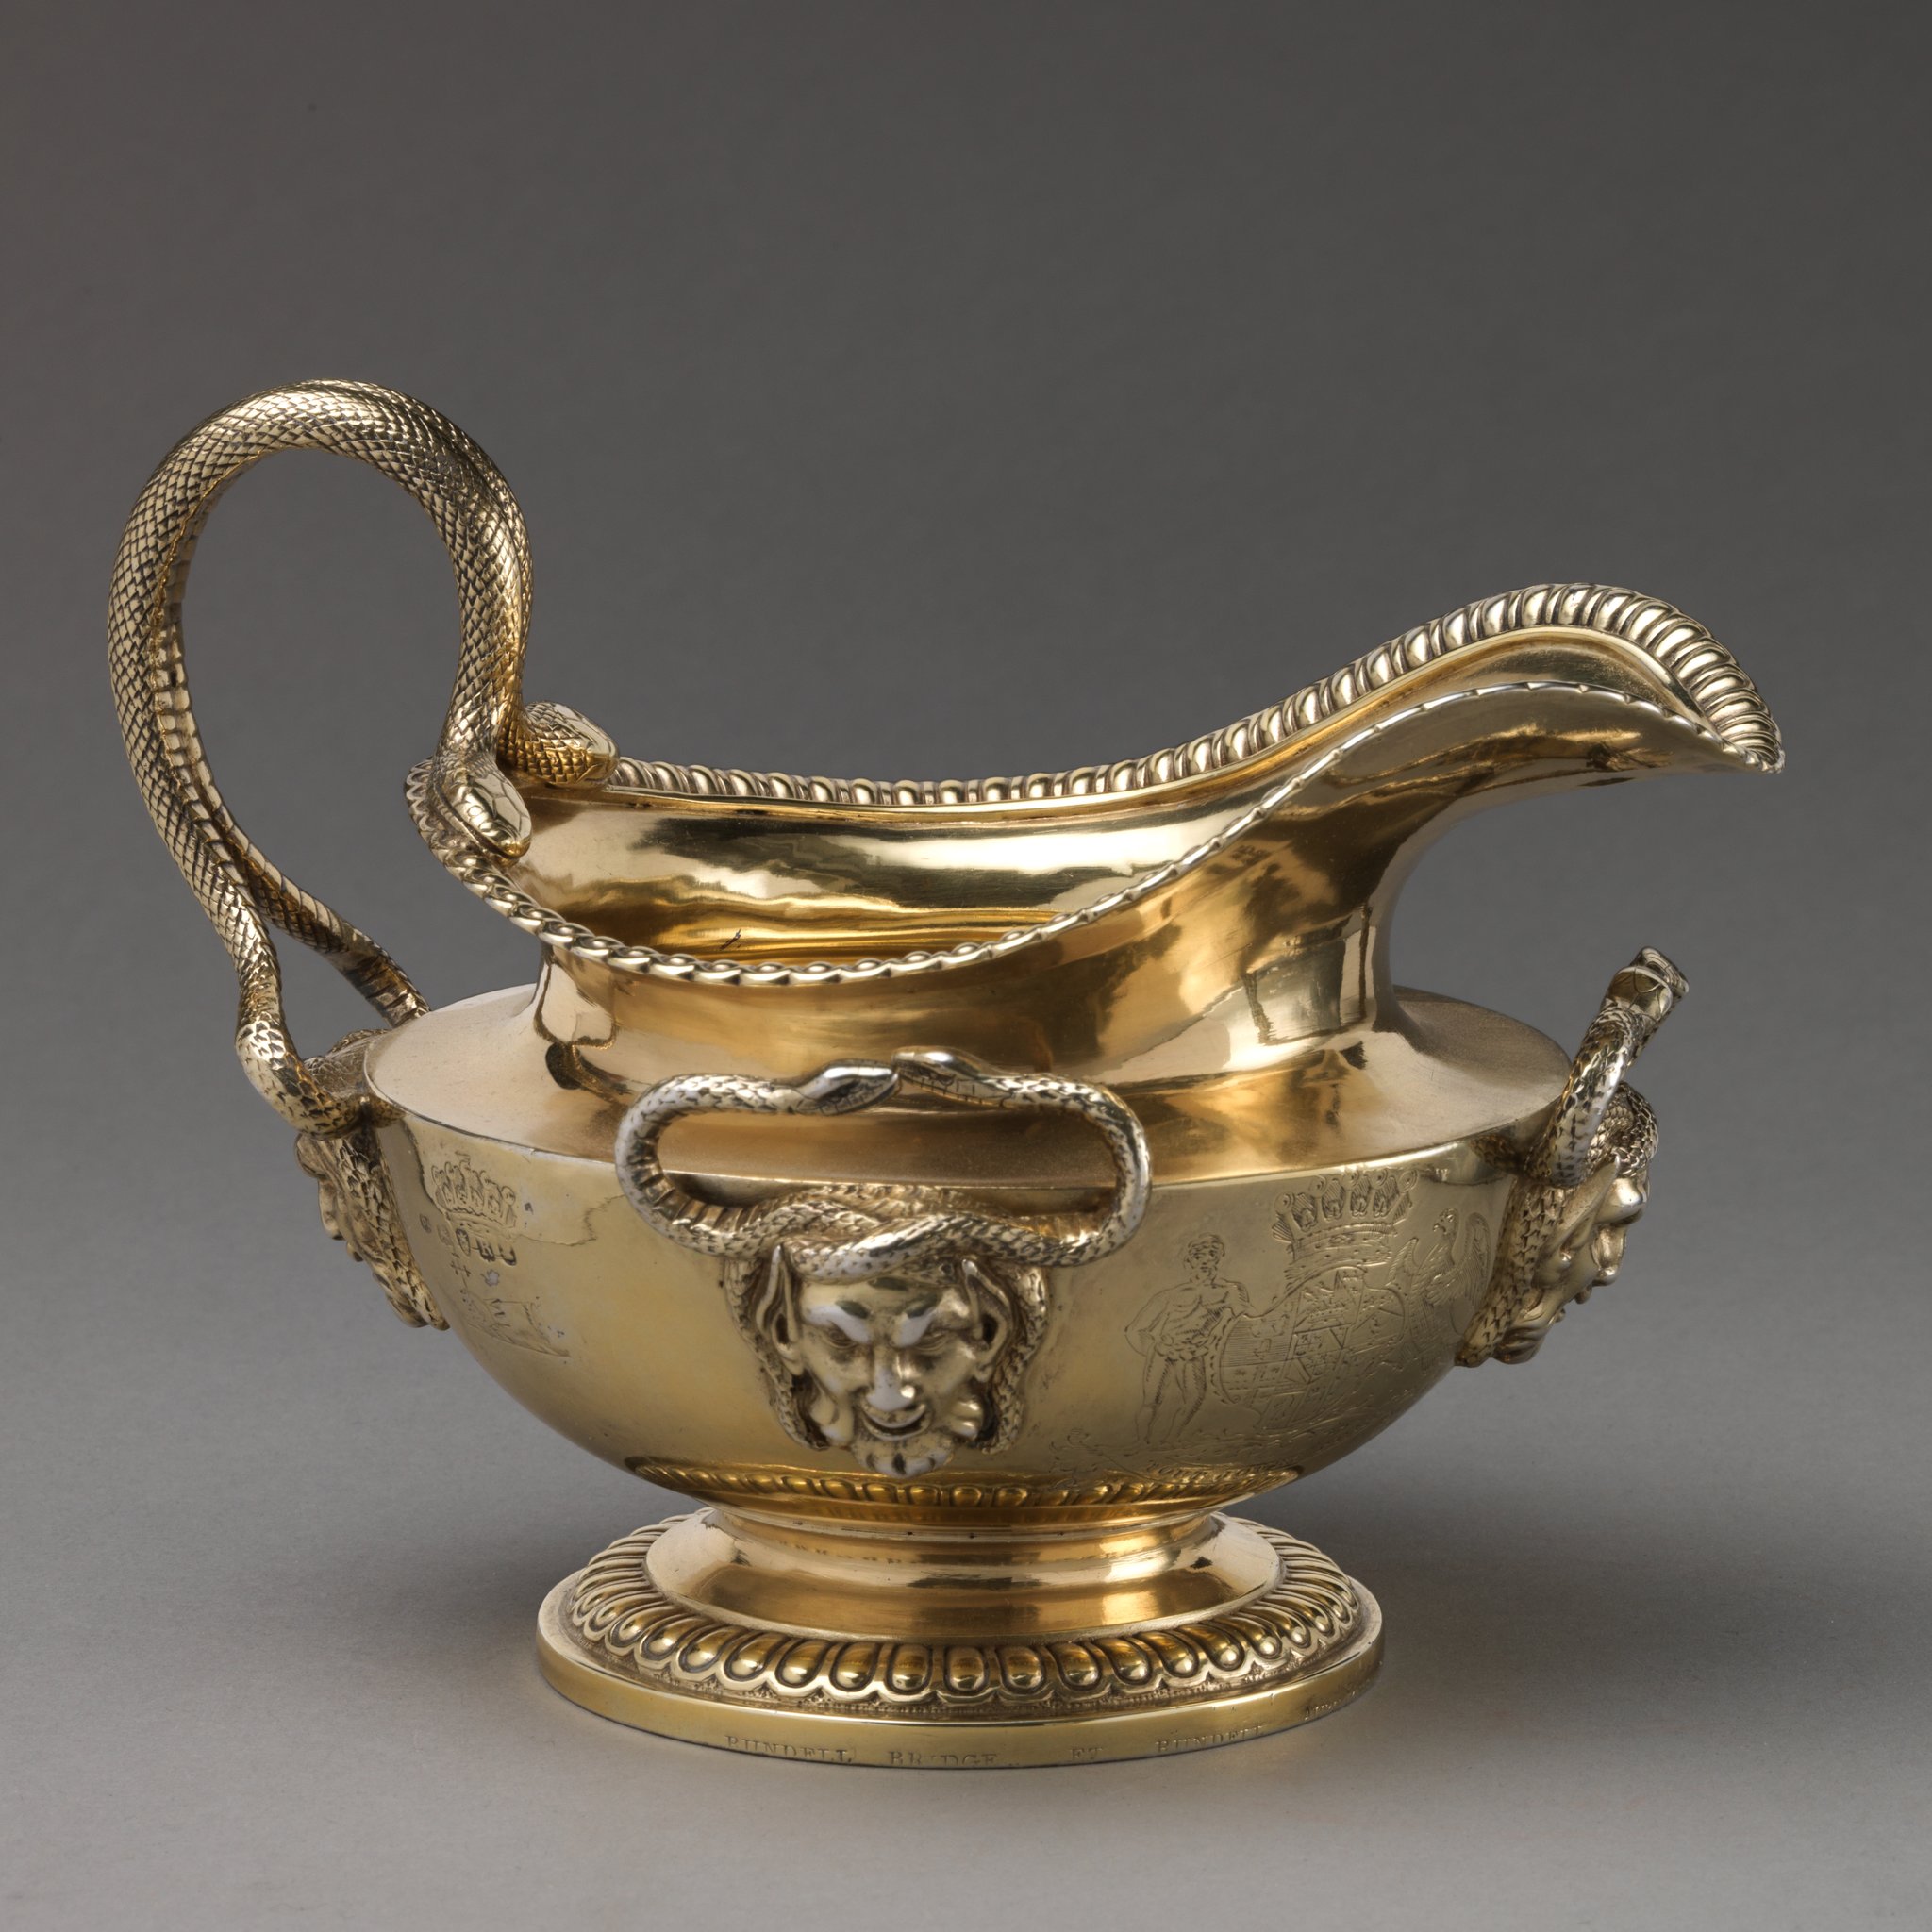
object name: cream jug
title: Cream jug (part of a set)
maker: paul storr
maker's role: maker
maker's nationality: british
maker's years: 1771-1844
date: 1812-1813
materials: silver gilt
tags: coat of arms